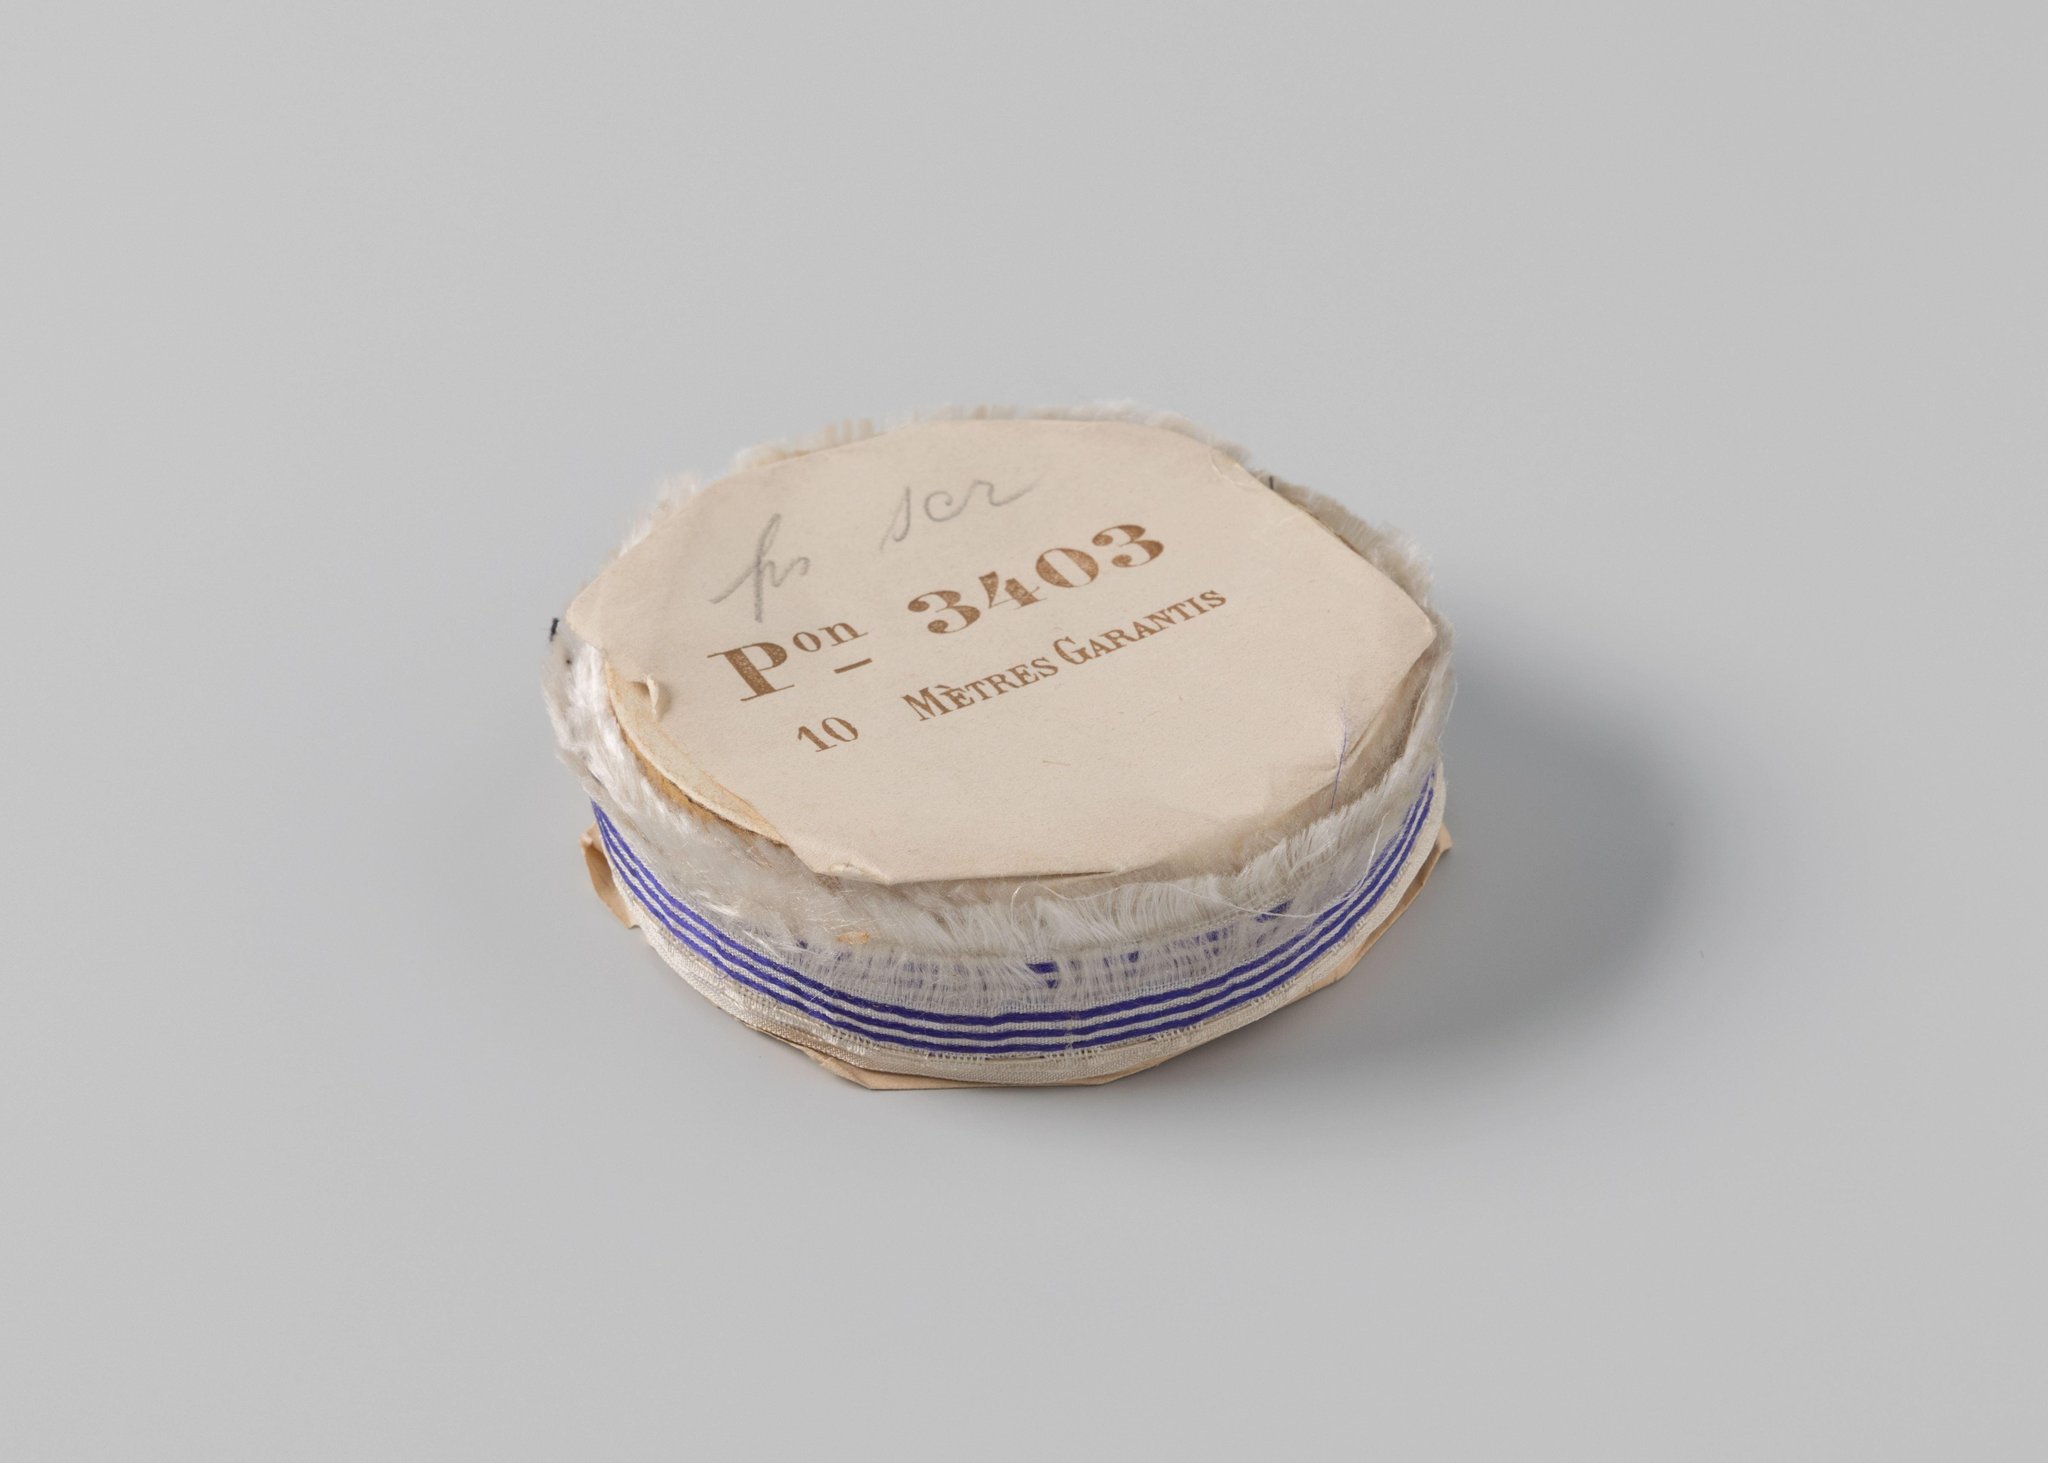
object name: braid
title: Rol met wit lint met één gerafelde zijde en drie blauwe horizontale strepen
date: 1930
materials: cardboard, paper, textile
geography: nijmegen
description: Rol met wit lint met één gerafelde zijde en drie blauwe horizontale strepen.